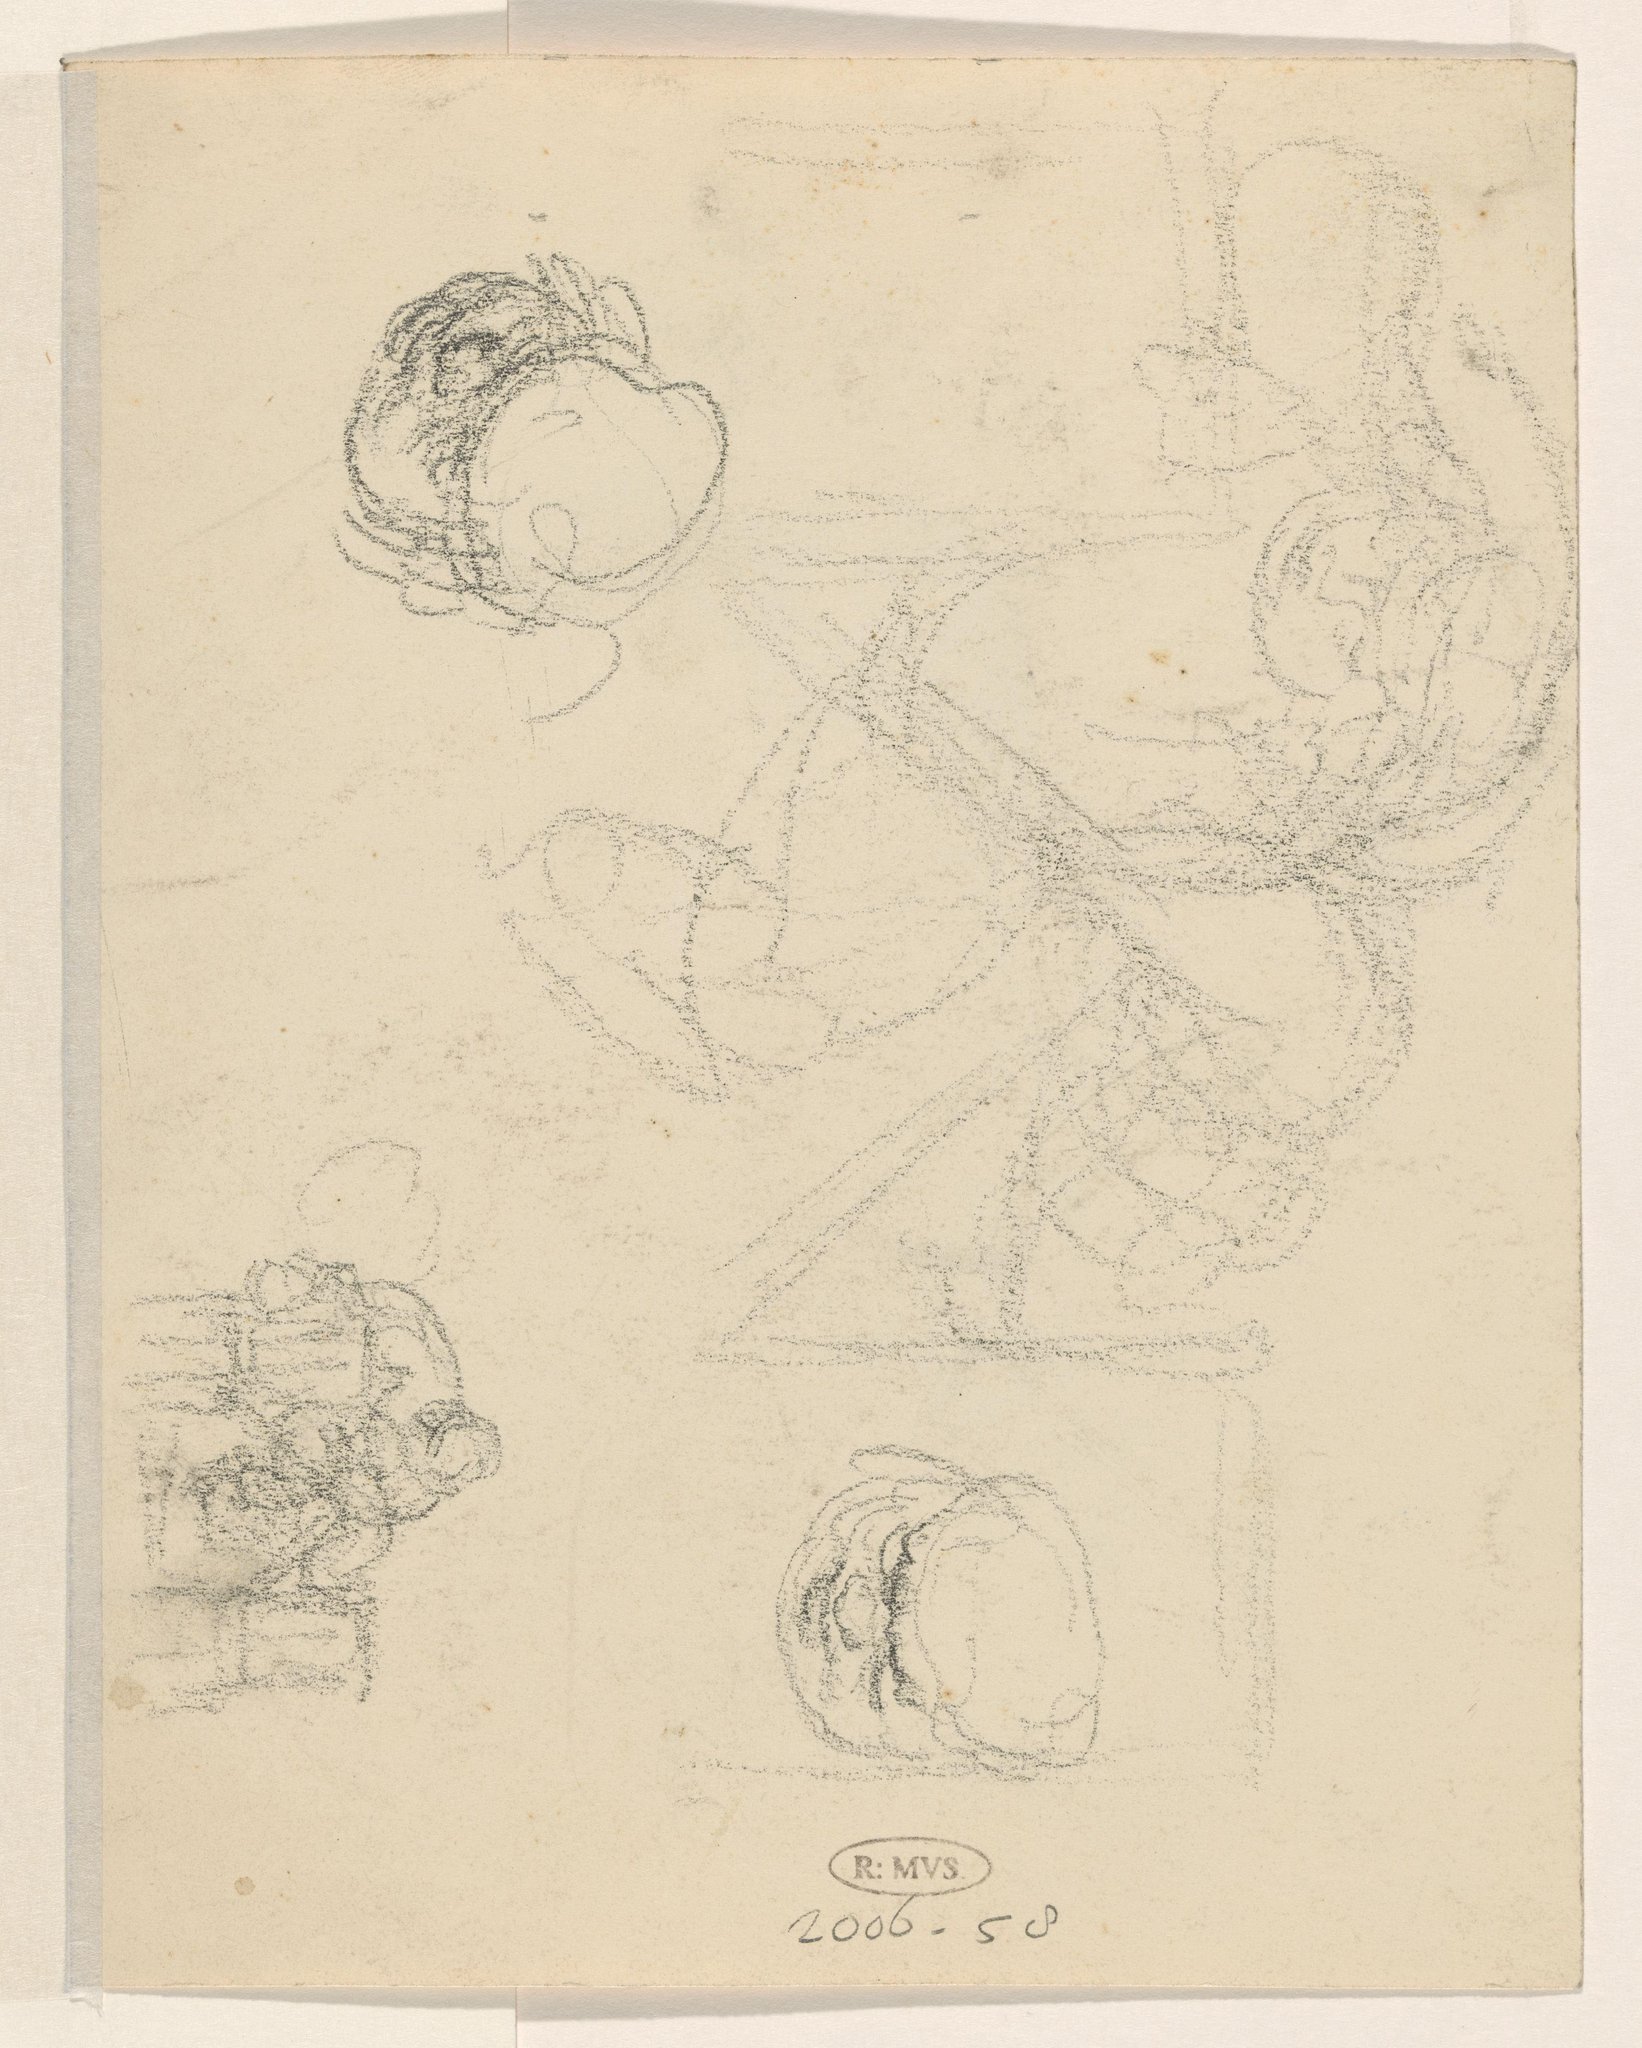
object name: drawing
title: Twee reuzen en twee gezichten van reuzen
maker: henk henriët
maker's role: draughtsman, print maker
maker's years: 1903-1945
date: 1936-1940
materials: paper, pencil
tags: face, giants, colossi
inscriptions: collector's mark: Lugt 2228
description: Deze tekening is mogelijk een ontwerp voor een illustratie bij het boek 'Gargantua en Pantagruel' van François Rabelais.